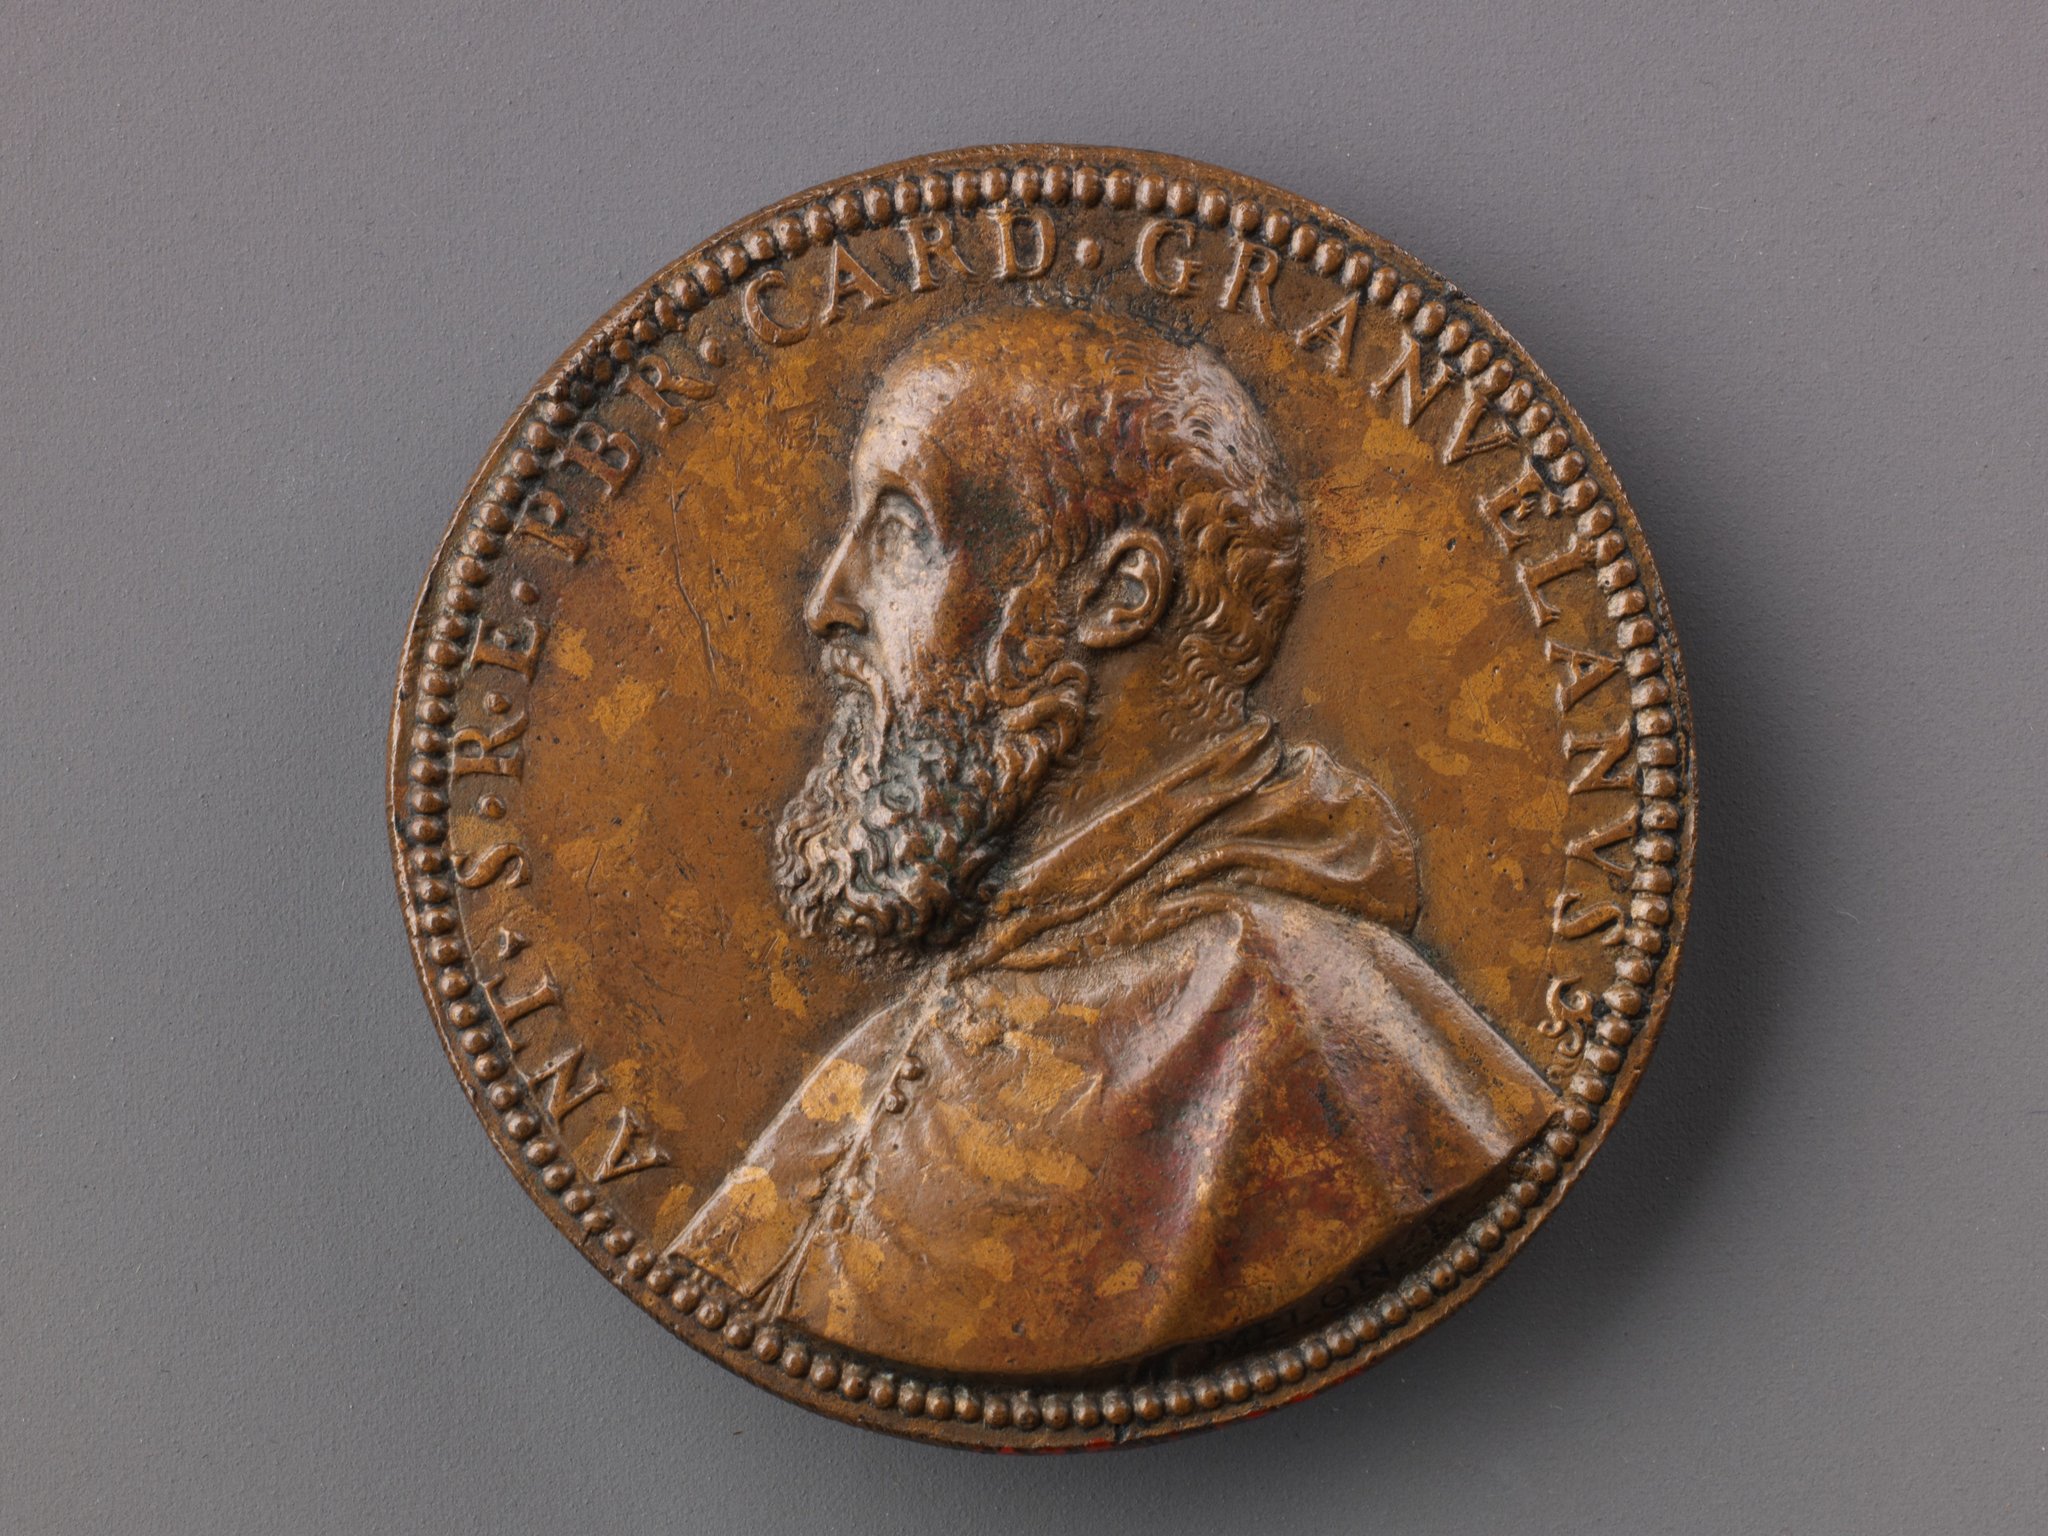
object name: medal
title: Portrait medal of Antoine Perrenot Granvelle (obverse); Don Juan of Austria Receiving the Standard from Granvelle (reverse)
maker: giovanni v. melon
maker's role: artist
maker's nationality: italian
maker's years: 1565-1590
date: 1571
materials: bronze, copper alloy, patina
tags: men,portraits,profiles